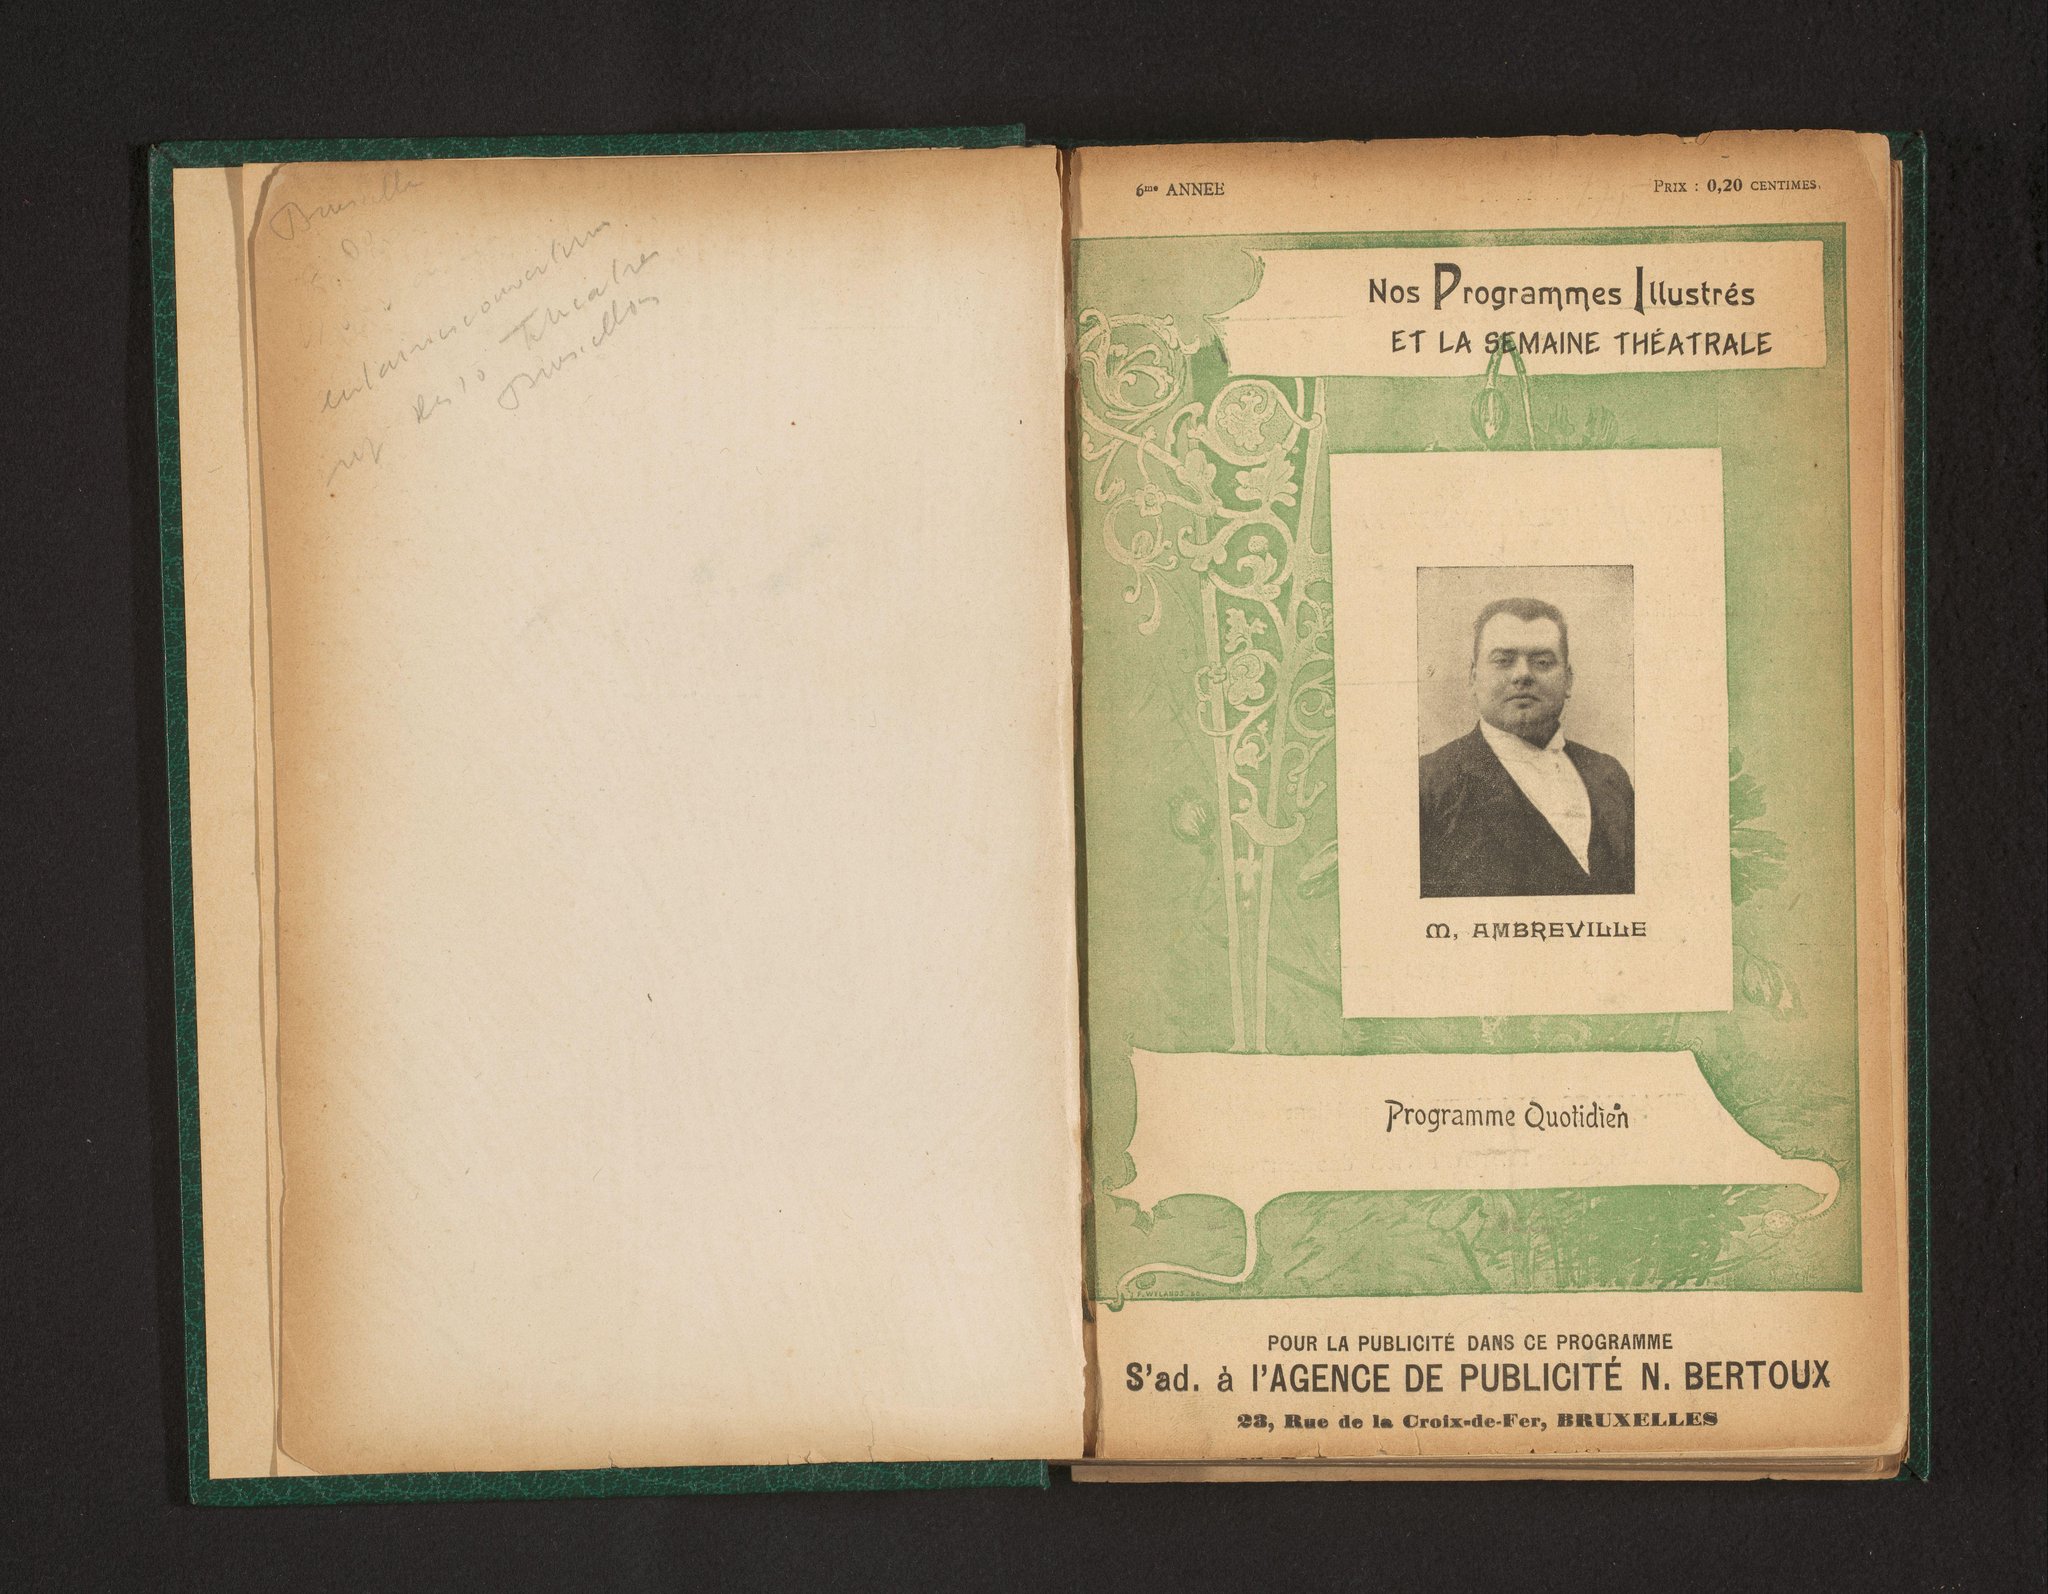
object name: magazine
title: Nos programmes illustrés et la semaine théâtrale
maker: Anonymous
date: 1900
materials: cardboard, leather, paper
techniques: photograph, printing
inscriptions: annotation: ‘FEB/ 1996’